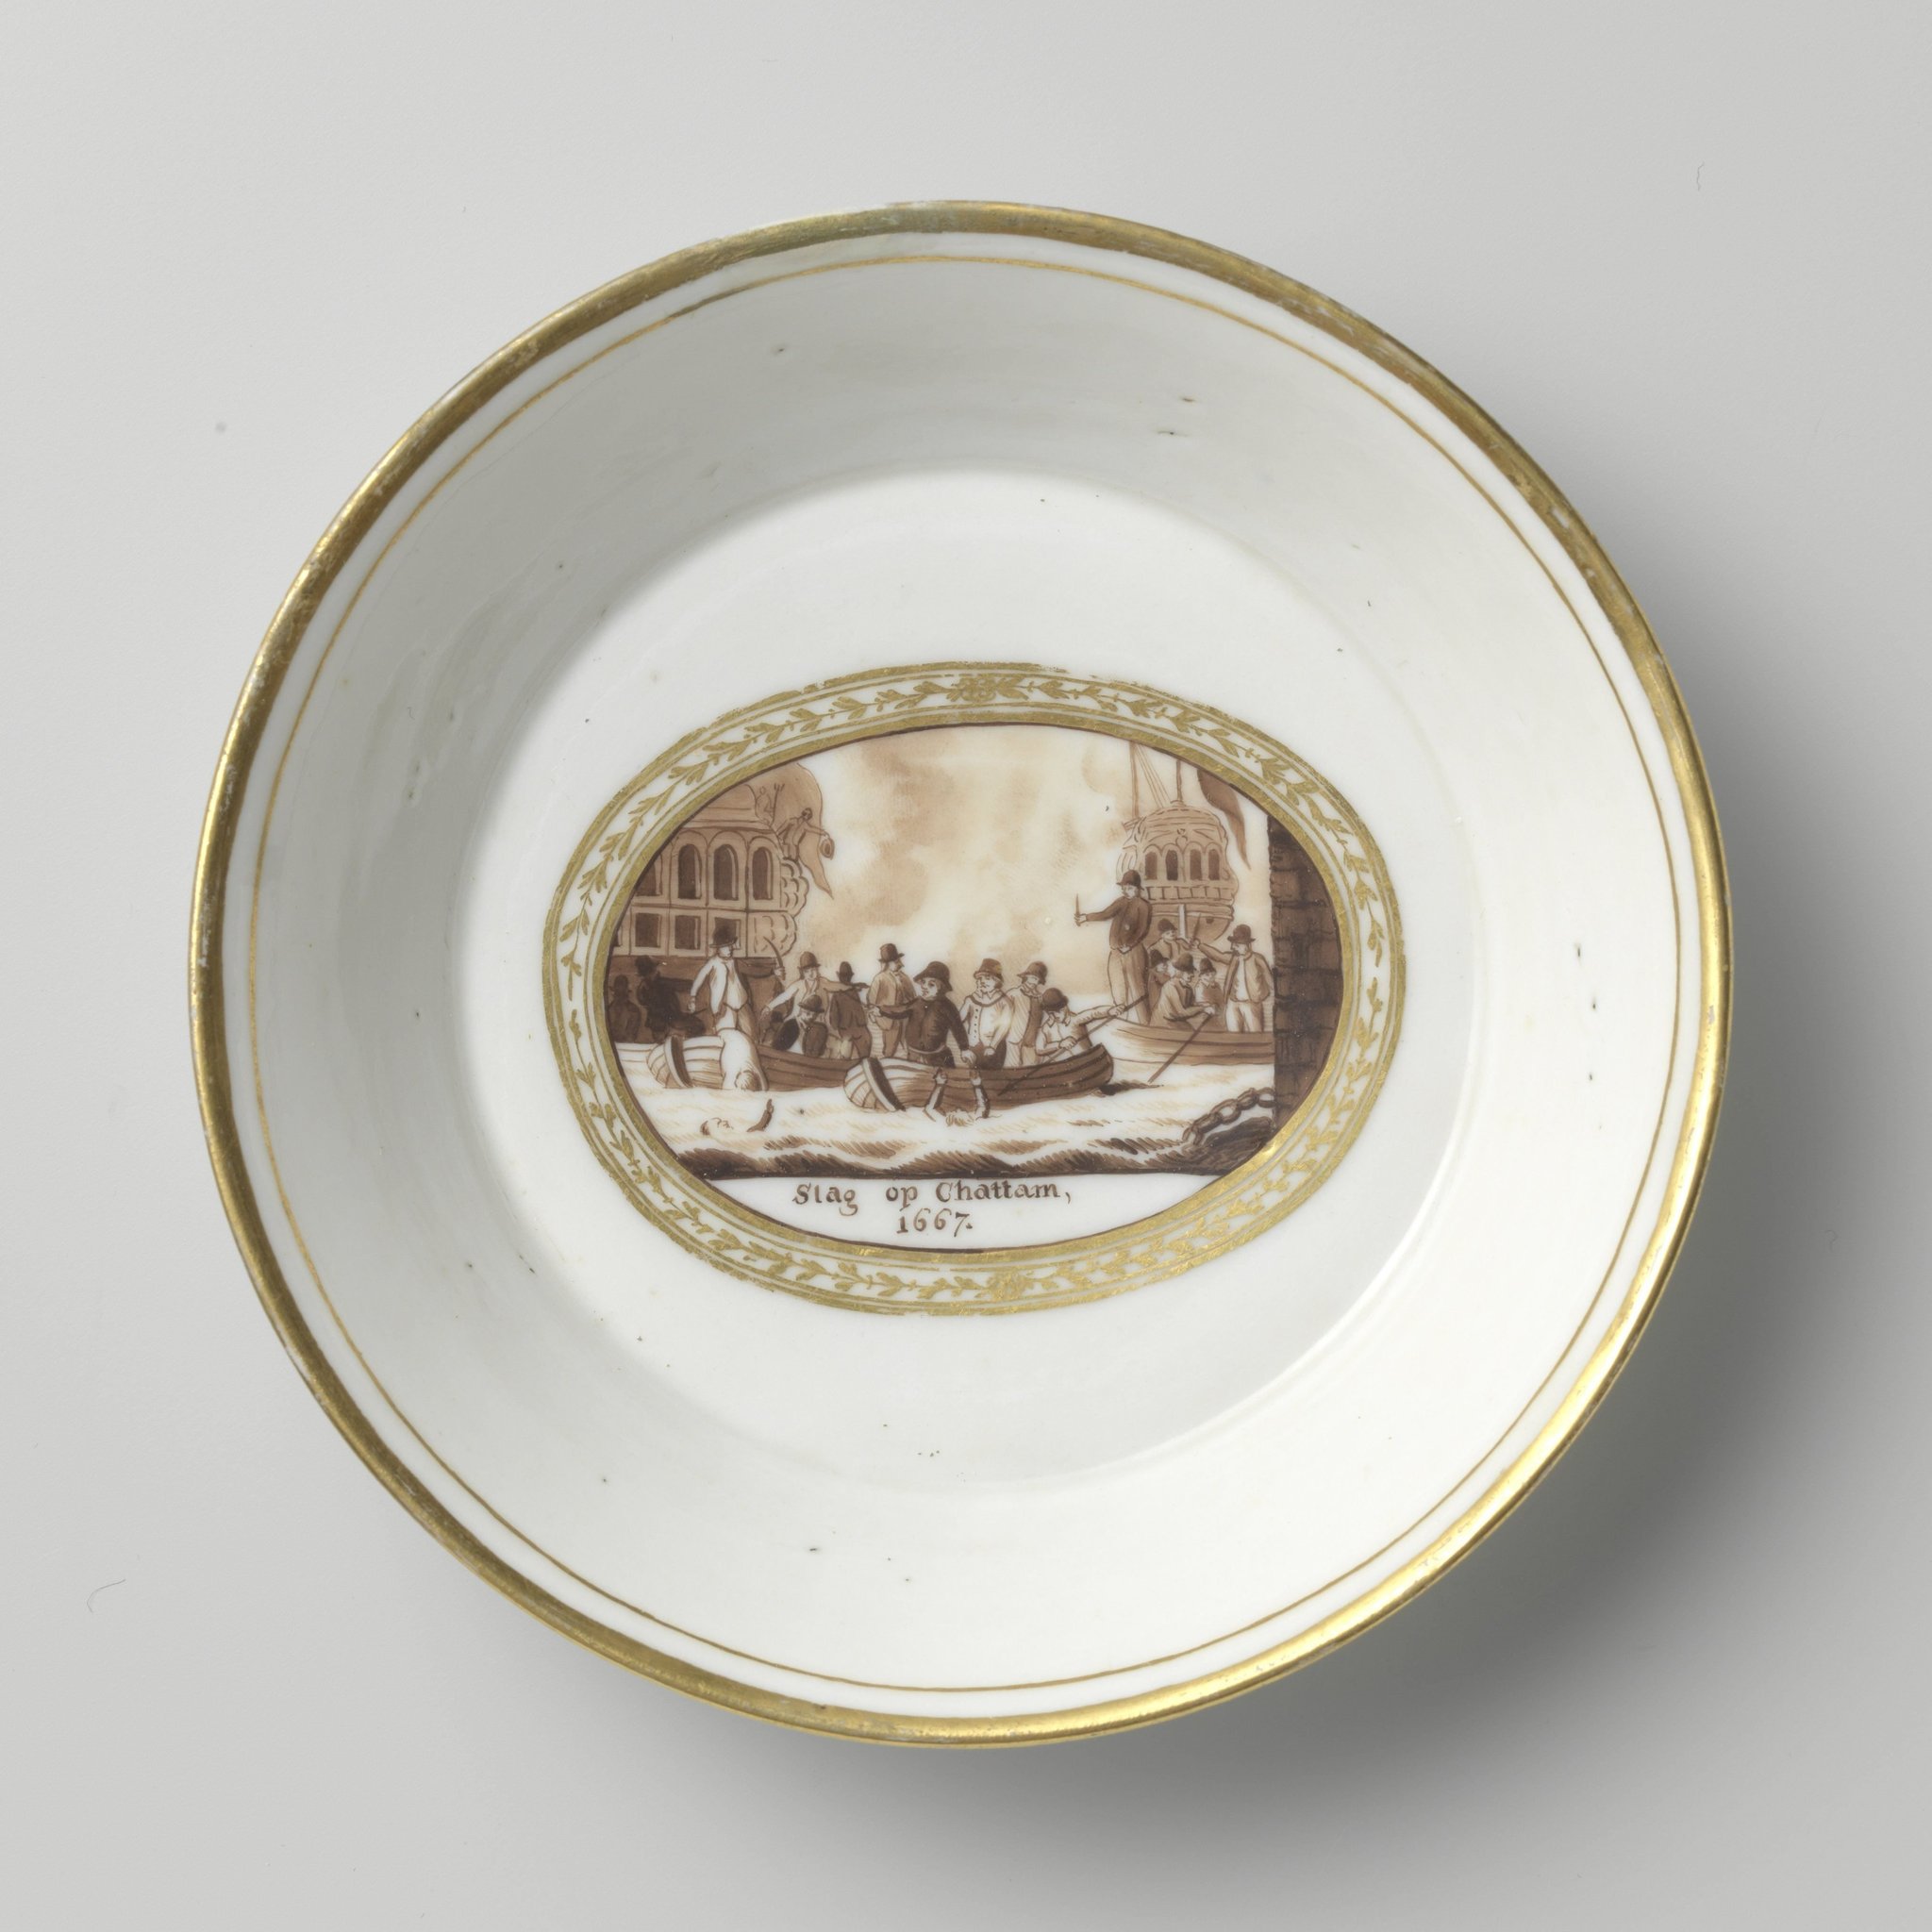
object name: platter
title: Saucer with an image of the Raid on the Medway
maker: Anonymous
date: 1794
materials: glaze, gold, paint, porcelain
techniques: firing, forming, gilding, turning, vitrification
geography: ilmenau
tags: raid on the medway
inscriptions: inscription: ‘SLAG OP CHATTAM. 1667’, mark: ‘103-N/ 14’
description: Schotel, één van een serie van tien,onderdeel van een servies met in bruin geschilderde medaillons waarin historische voorvallen en portretten van personen uit de vaderlandse geschiedenis. De schotel is gedecoreerd met een voorstelling van de Tocht naar Chatham uit 1667. Gemerkt.